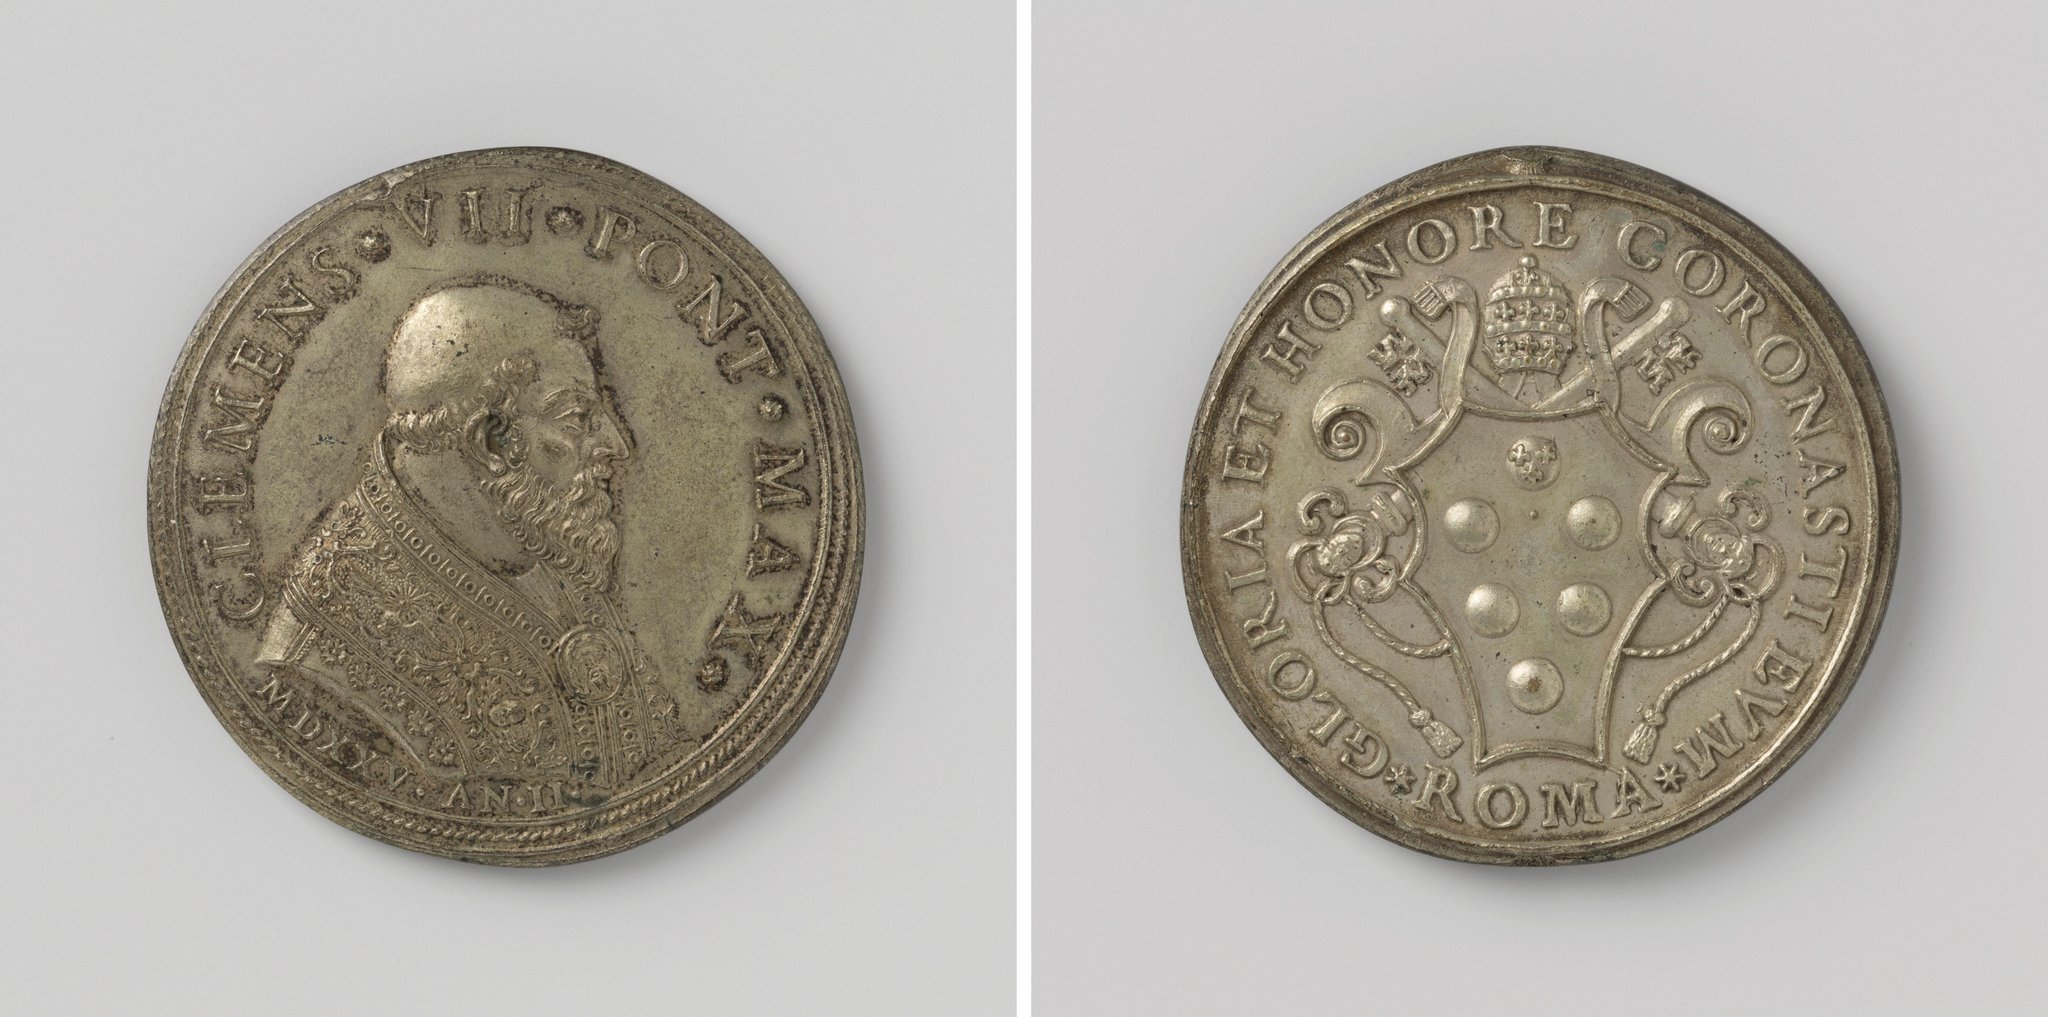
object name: history medal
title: Jubeljaar van Clemens VII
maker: Anonymous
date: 1524-1525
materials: bronze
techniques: striking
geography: italy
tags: rome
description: Bronzen penning. Voorzijde: borststuk man binnen omschrift. Keerzijde: wapenschilden onder tiara en twee gekruiste sleutels binnen omschrift